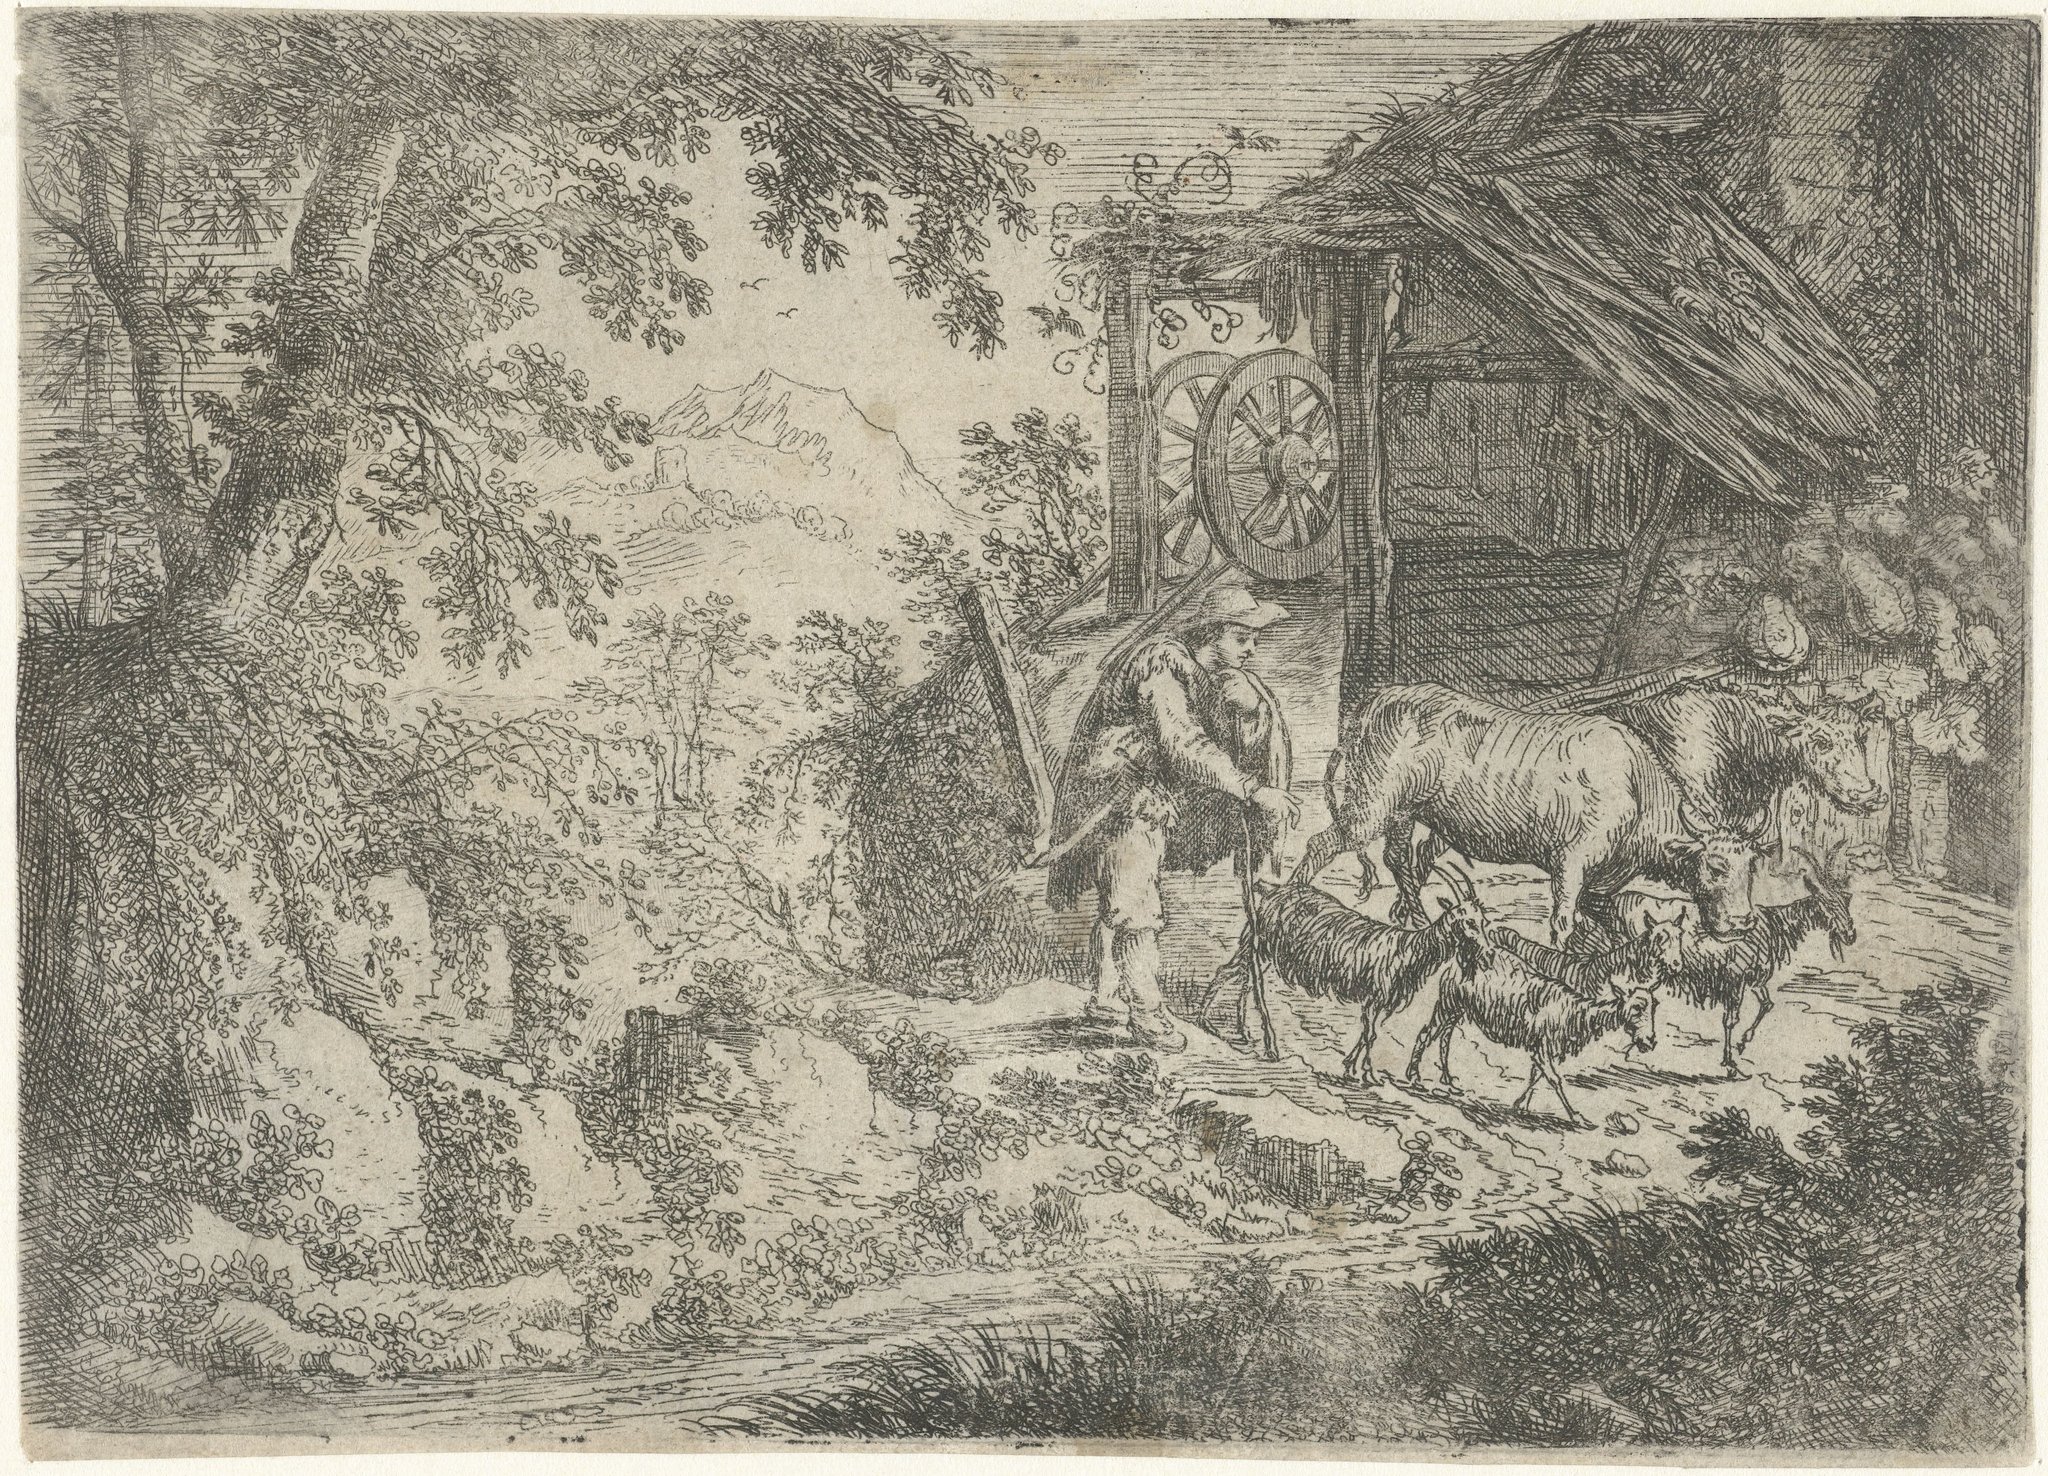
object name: print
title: Herder met geiten en koeien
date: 1637-1656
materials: paper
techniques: engraving, etching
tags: cow, cattle driving, cattle driver, goat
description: Een herder met twee koeien en wat geiten in een landschap. Op de achtergrond een schuur.